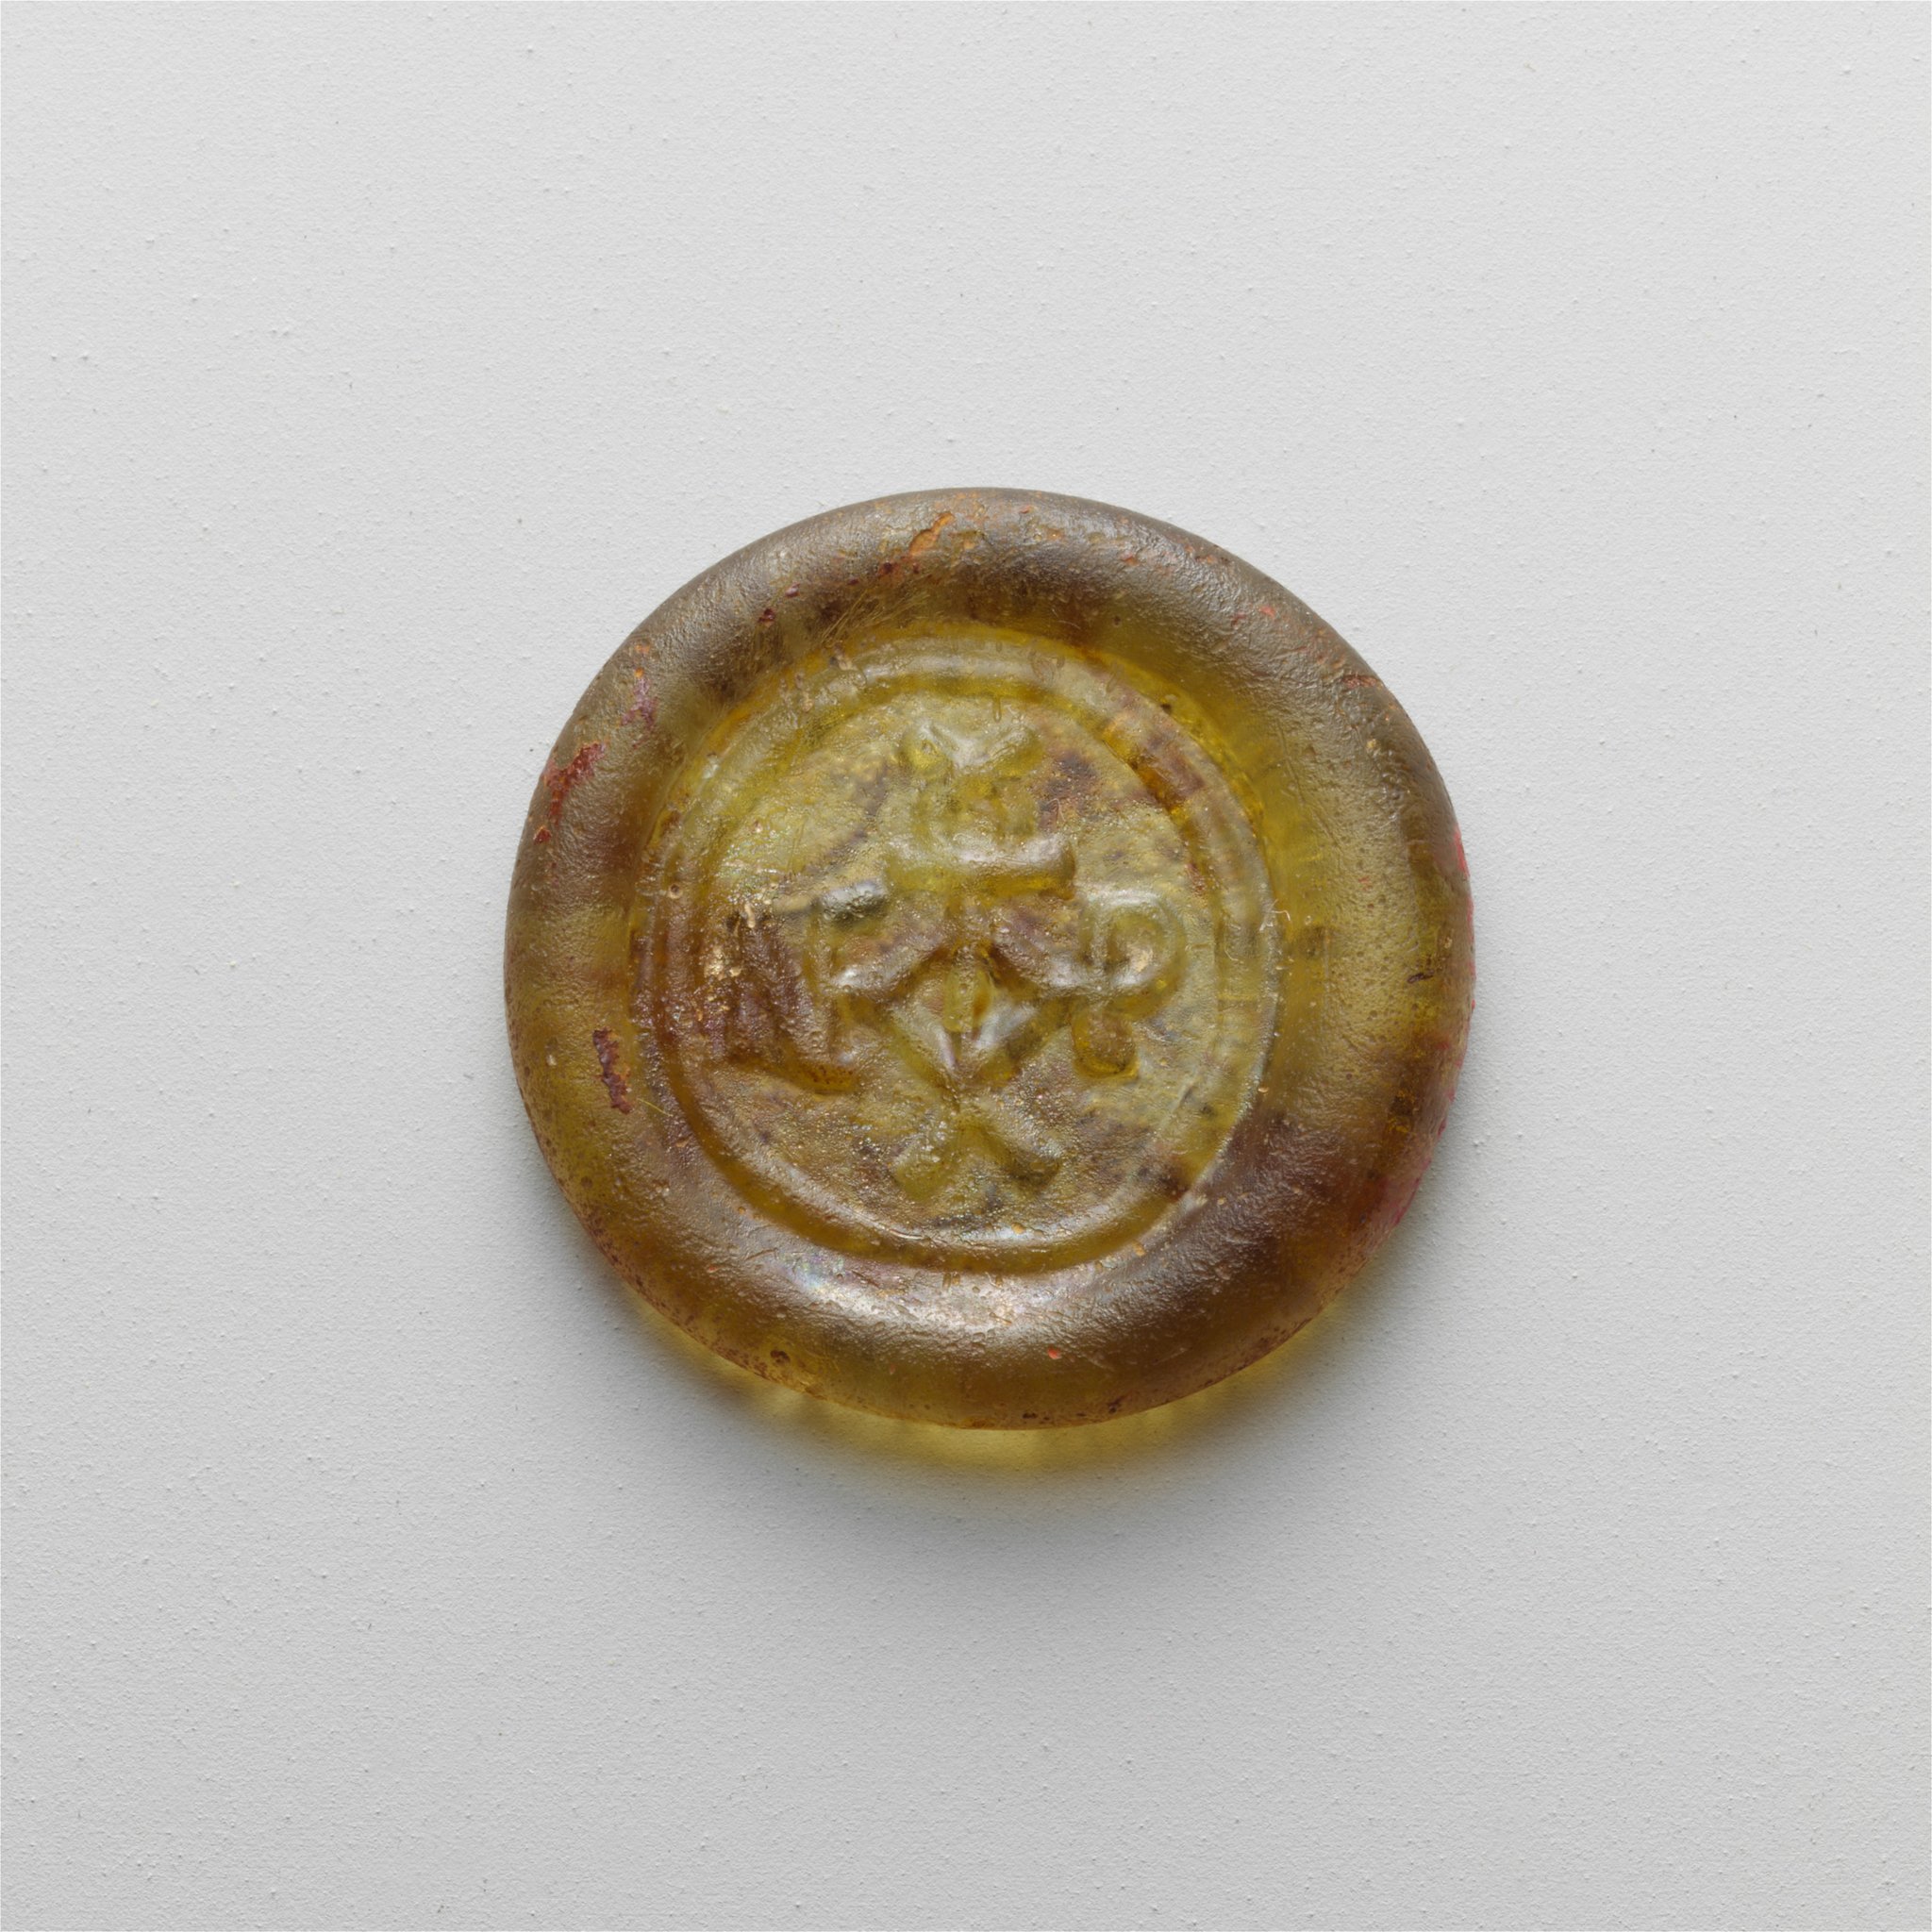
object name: weight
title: Glass weight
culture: roman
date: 501-633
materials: glass